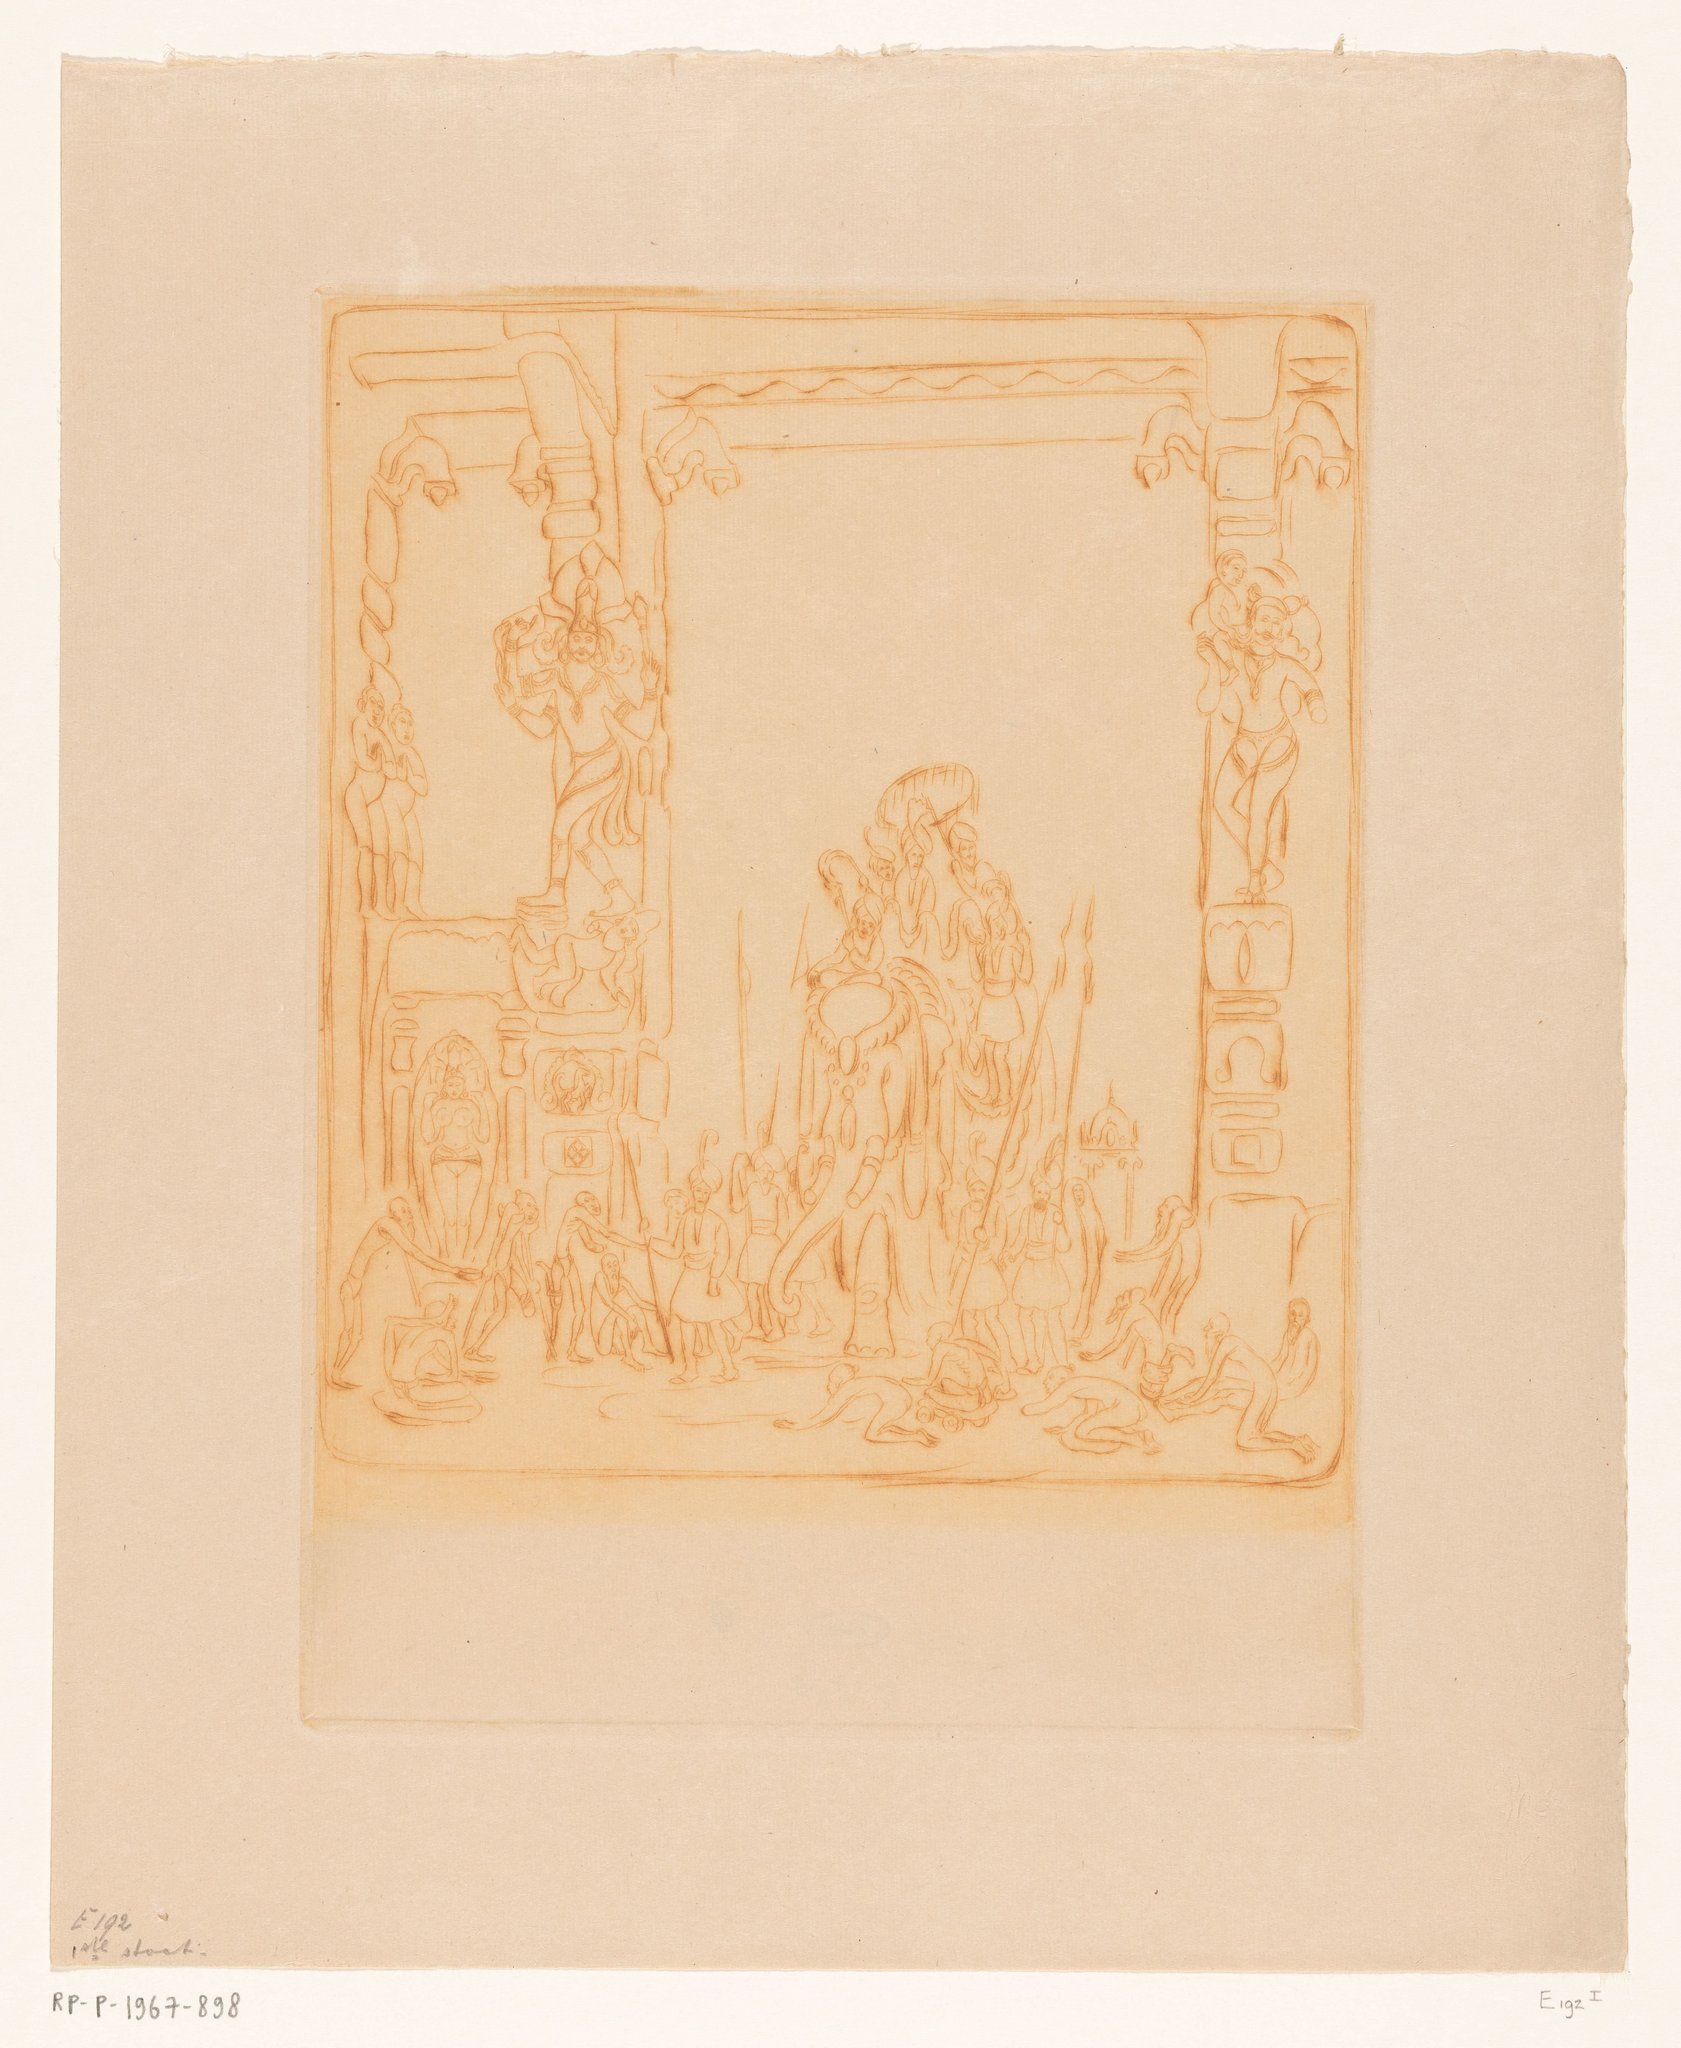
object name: print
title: Figuren op een olifant onder een poort in Madurai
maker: wijnand otto jan nieuwenkamp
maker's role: draughtsman, print maker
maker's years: 1874-1950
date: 1917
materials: paper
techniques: drypoint, intaglio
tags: contrast between rich and poor, riding on animal other than horse, ass, or mule, beggar, city-gate, trunked animals: elephant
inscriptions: collector's mark: Lugt 2228, collector's mark: Lugt 2760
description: De olifant wordt begeleid door figuren met lansen. De poort is versierd met sculpturen. Op de voorgrond knielende figuren die hun handen ophouden in een bedelend gebaar.